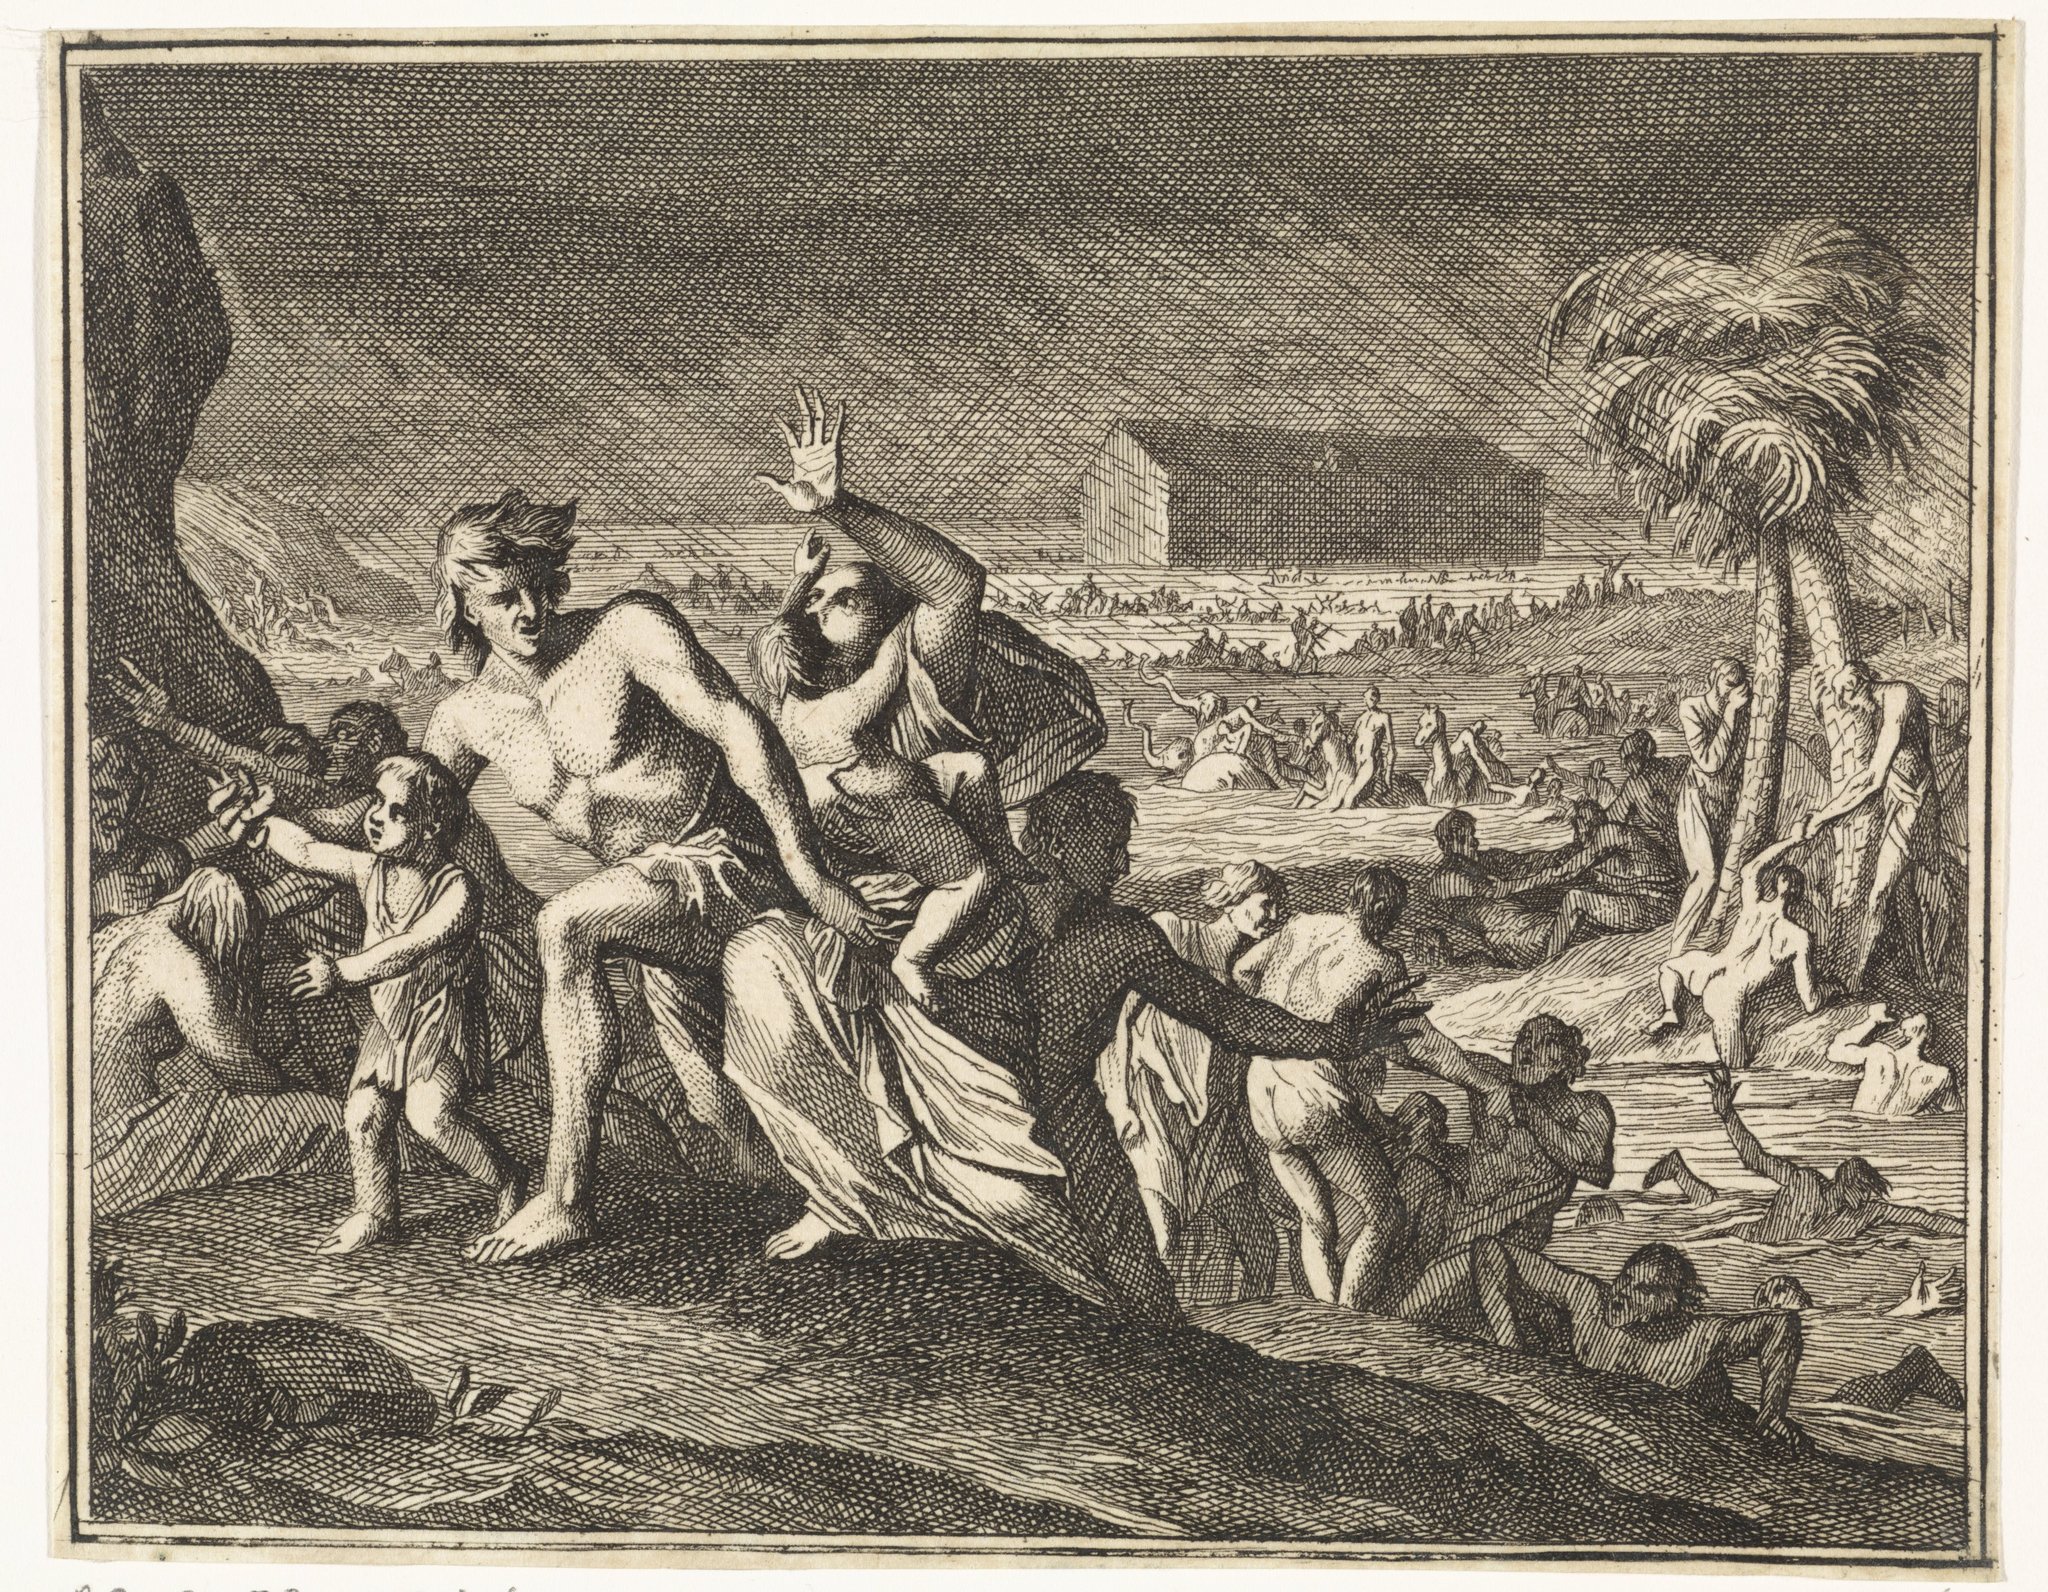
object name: print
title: Zondvloed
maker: caspar luyken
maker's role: draughtsman, print maker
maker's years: 1672-1708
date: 1712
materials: paper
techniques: etching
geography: amsterdam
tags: the flood and destruction of mankind ~ story of noah (genesis 7:10 - 8:17)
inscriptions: collector's mark: Lugt 2228, number: ‘13’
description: Illustratie uit: Luyken, Jan. De schriftuurlyke geschiedenissen en gelykenissen van het Oude en Nieuwe Verbond, 2 delen. Amsterdam: Wed. Pieter Arentsz II en Cornelis van der Sys, 1712, dl. I.